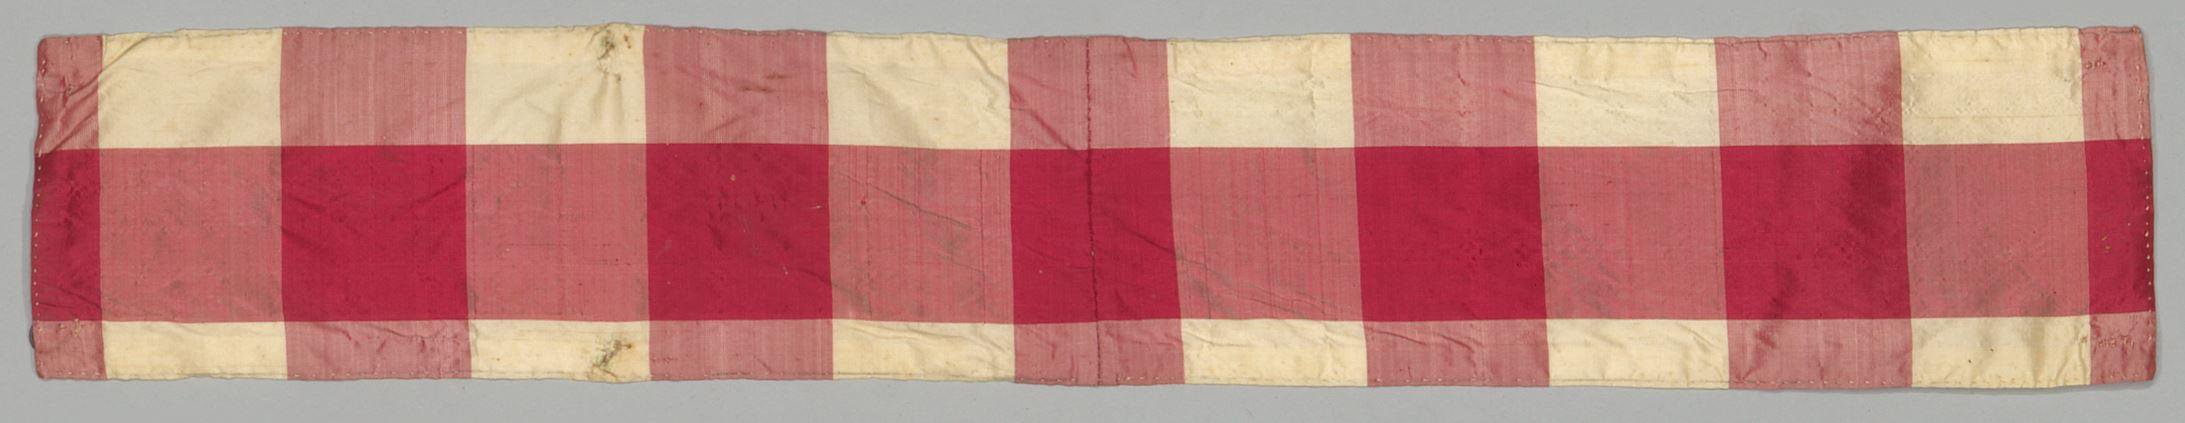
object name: tieback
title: Embrasse van rood-wit geblokte zijde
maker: Anonymous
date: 1776-1800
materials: linen, silk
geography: northern netherlands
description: Embrasse van rood-wit geblokte zijde, gevoerd met wit linnen en met twee stel metalen haken en ogen.